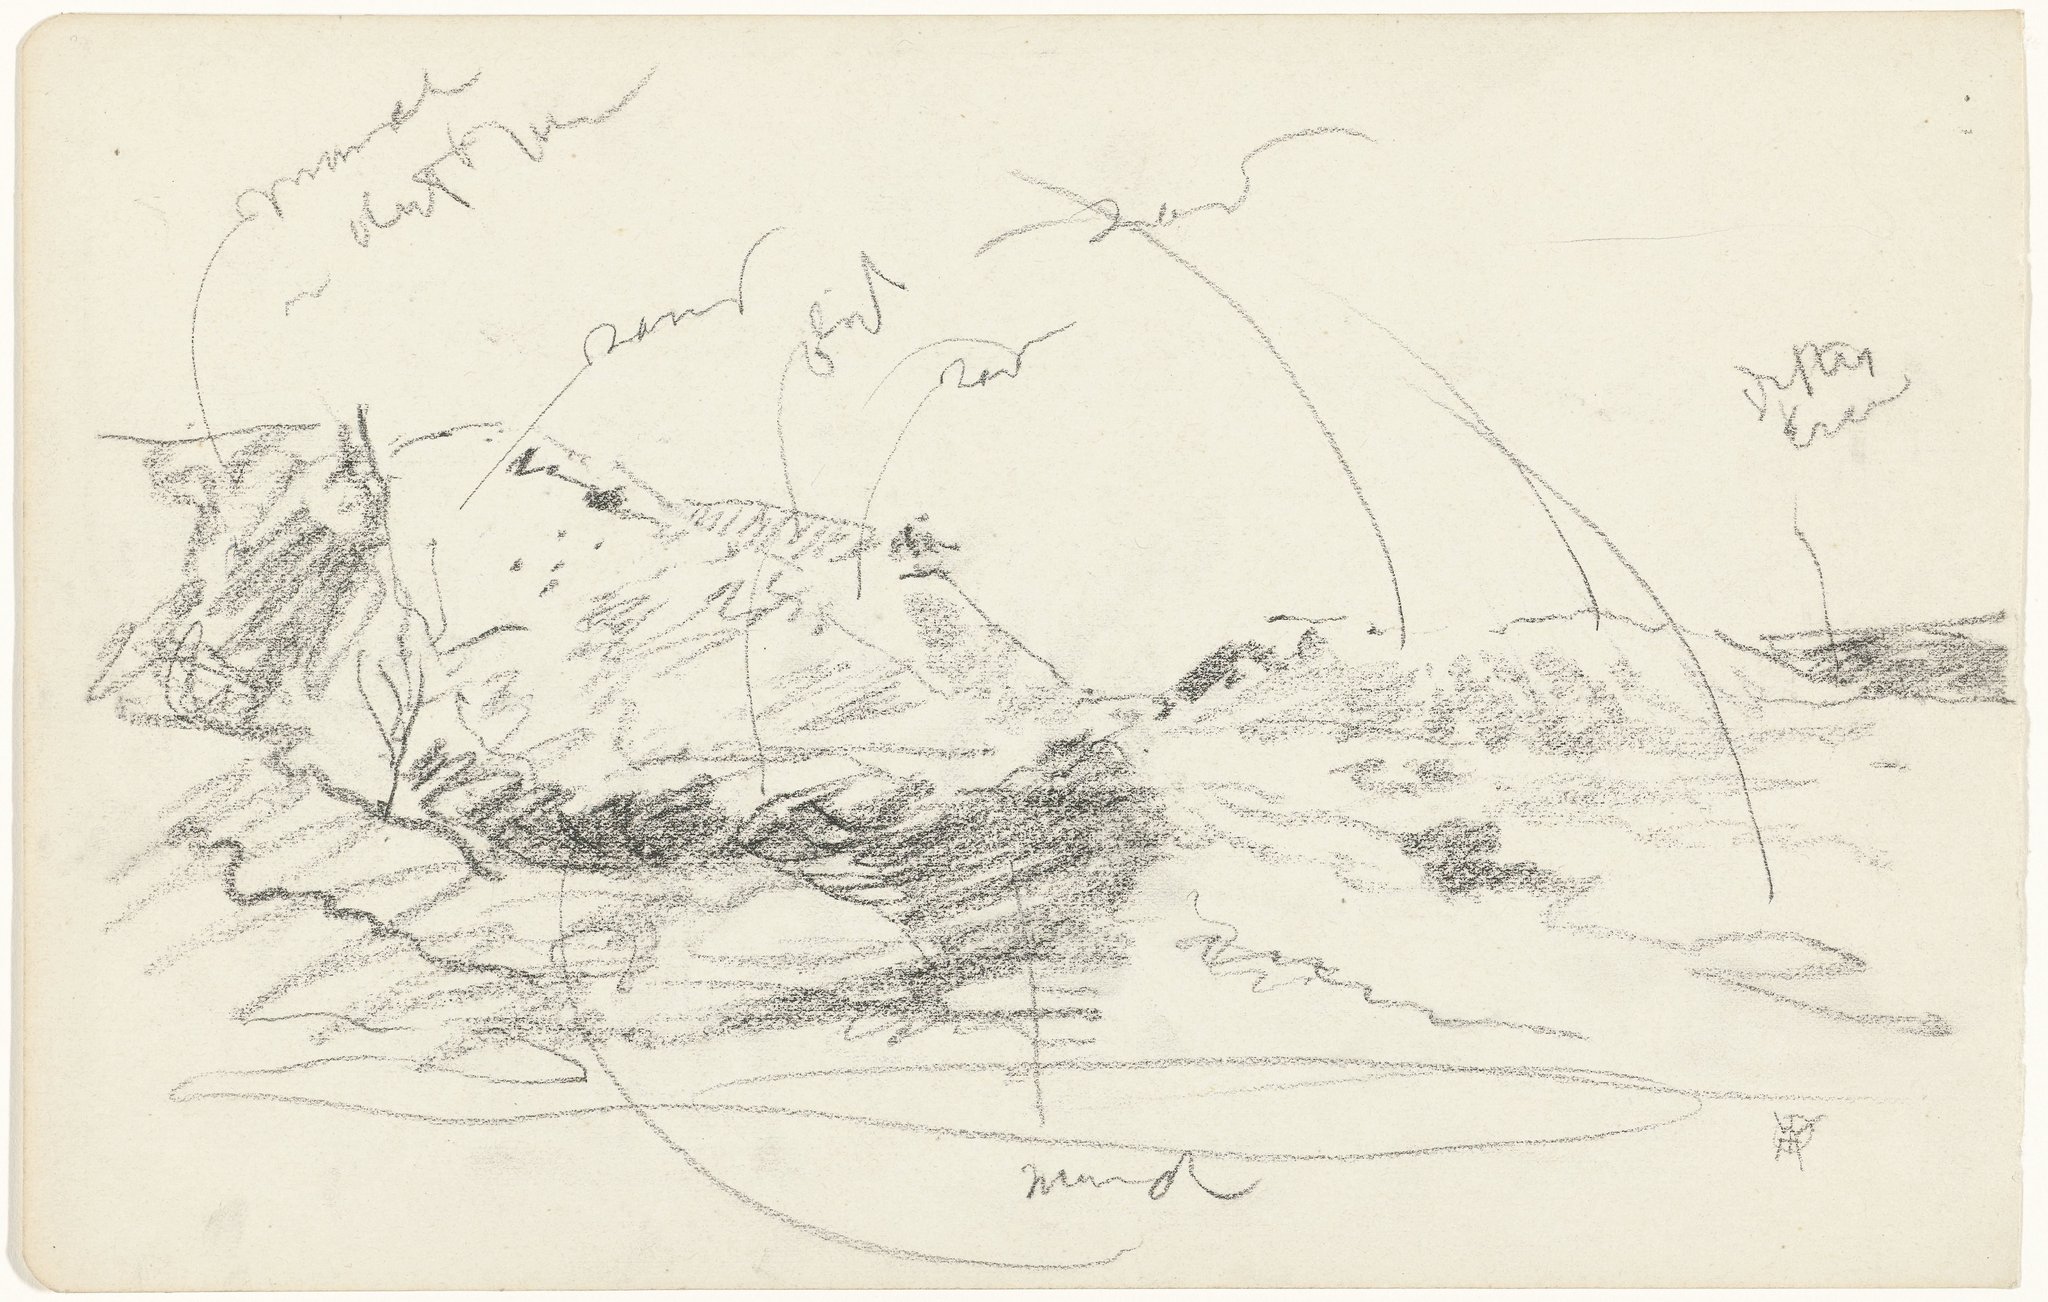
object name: drawing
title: Duinlandschap, met kleurnotities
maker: gerrit willem dijsselhof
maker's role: designer, draughtsman, print maker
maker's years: 1866-1924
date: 1876-1924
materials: chalk, paper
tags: dunes (sea not visible); in the dunes